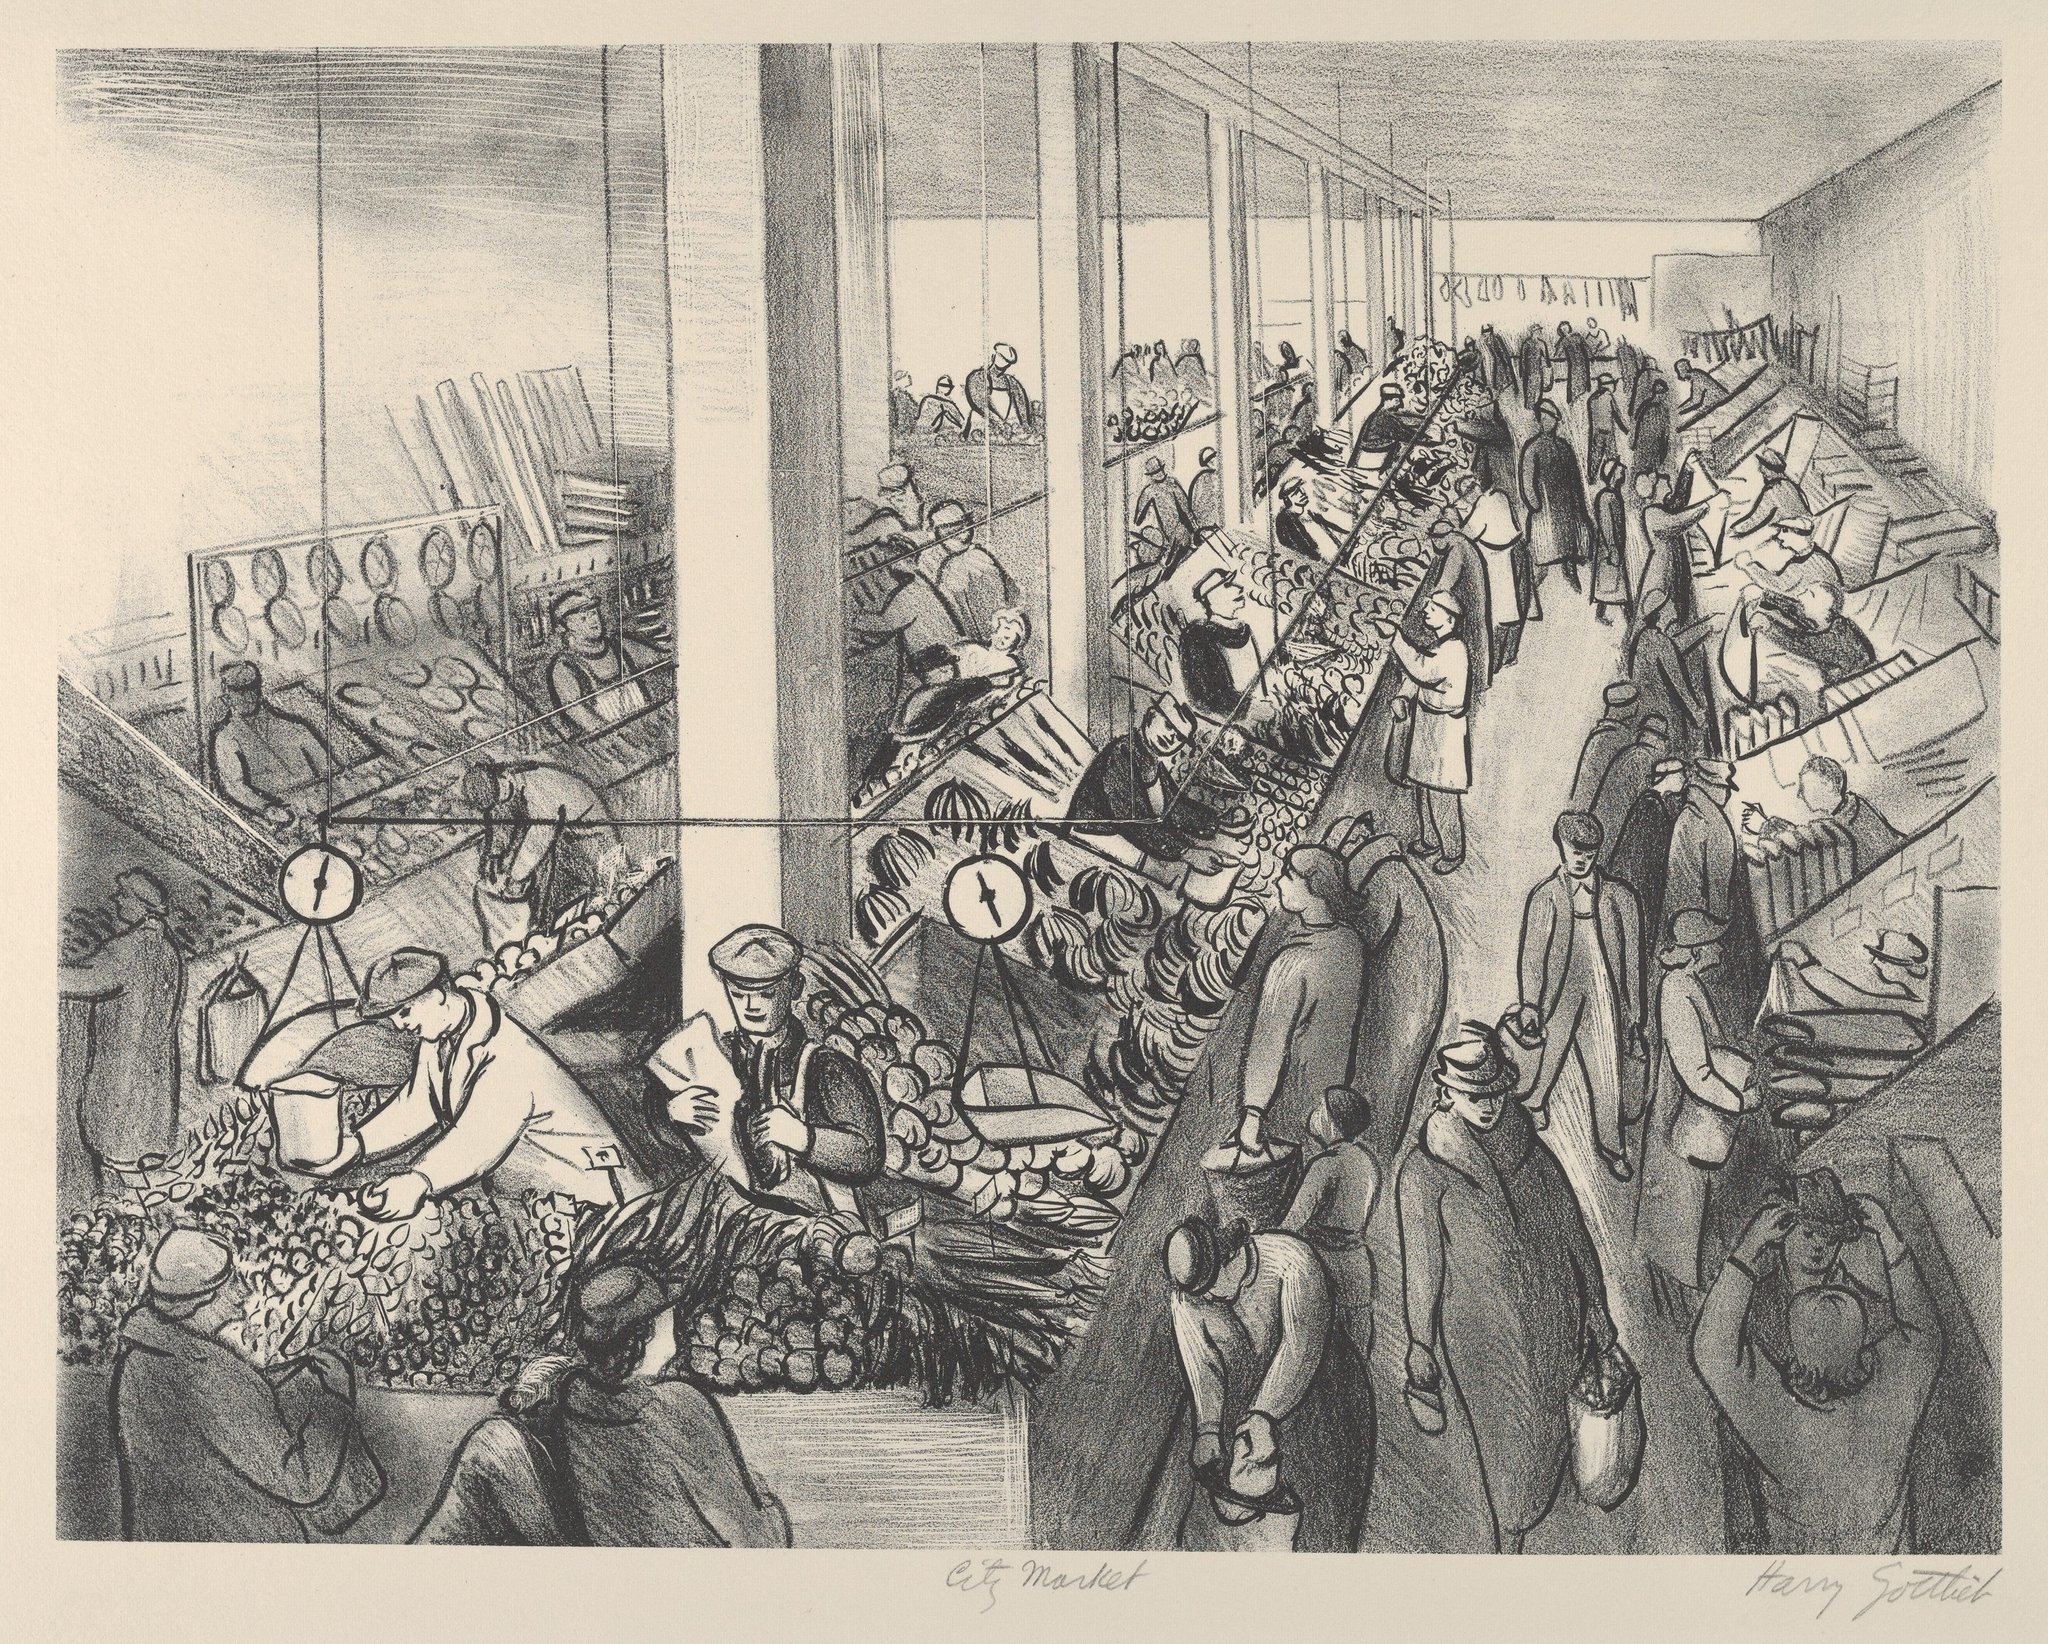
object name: print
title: City Market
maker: harry gottlieb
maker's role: artist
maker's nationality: american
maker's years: 1894-1992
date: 1935-1943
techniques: lithograph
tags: vegetables,men,women,markets